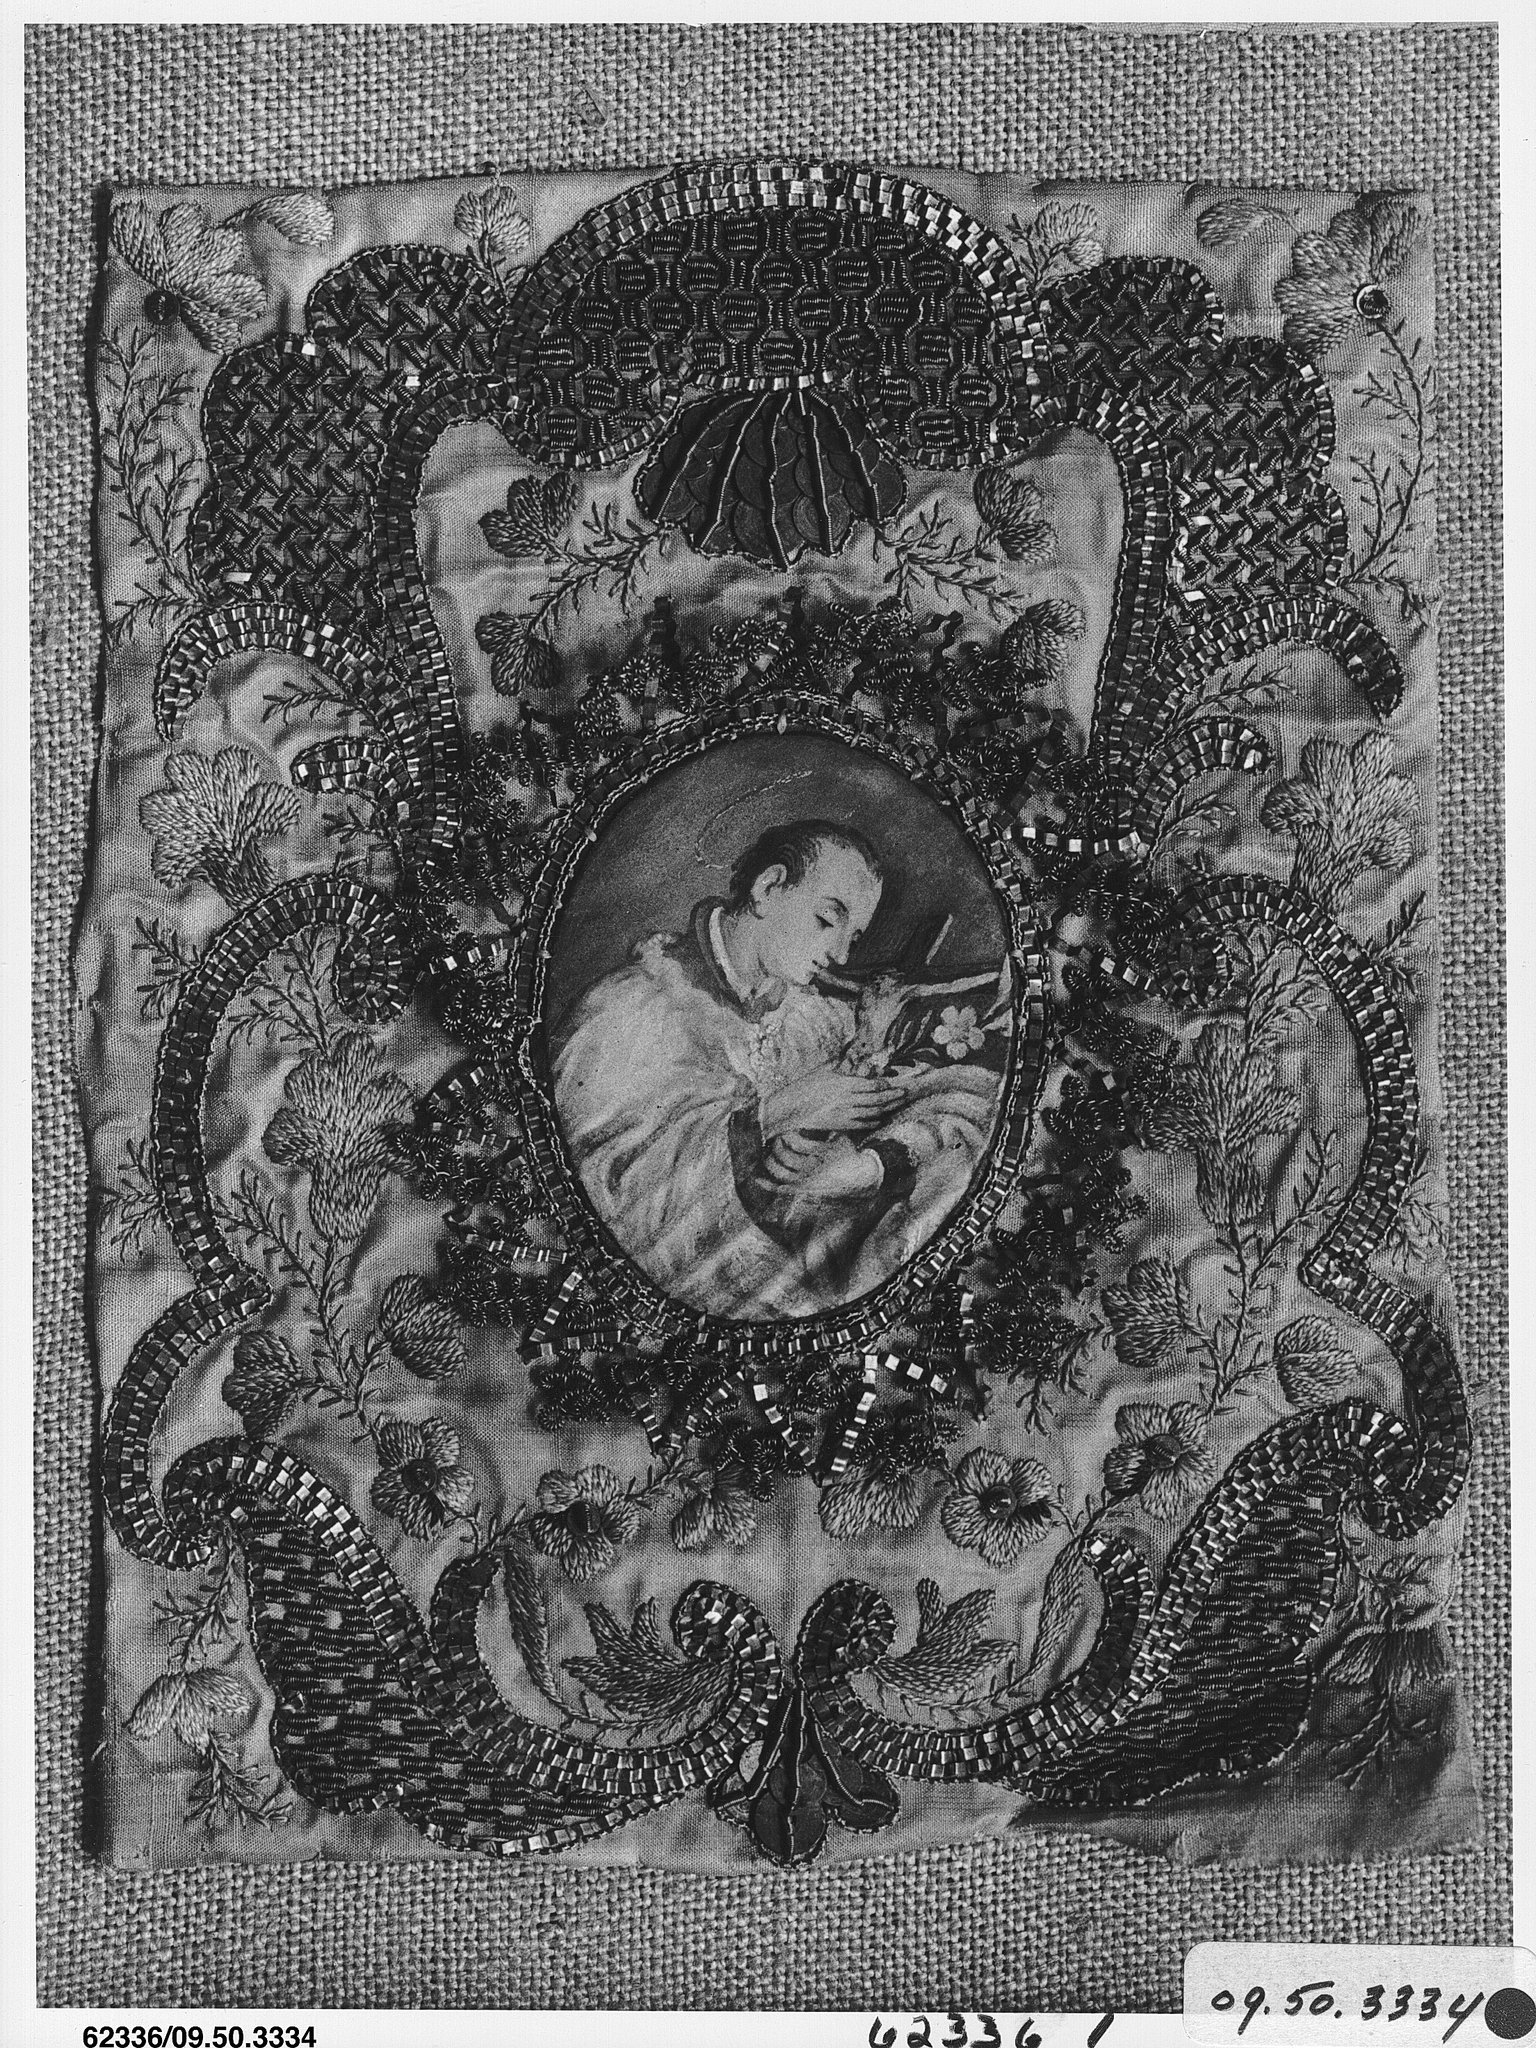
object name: book cover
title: Cover for a prayer book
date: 1701-1800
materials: metal thread, silk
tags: men,flowers,crucifixion